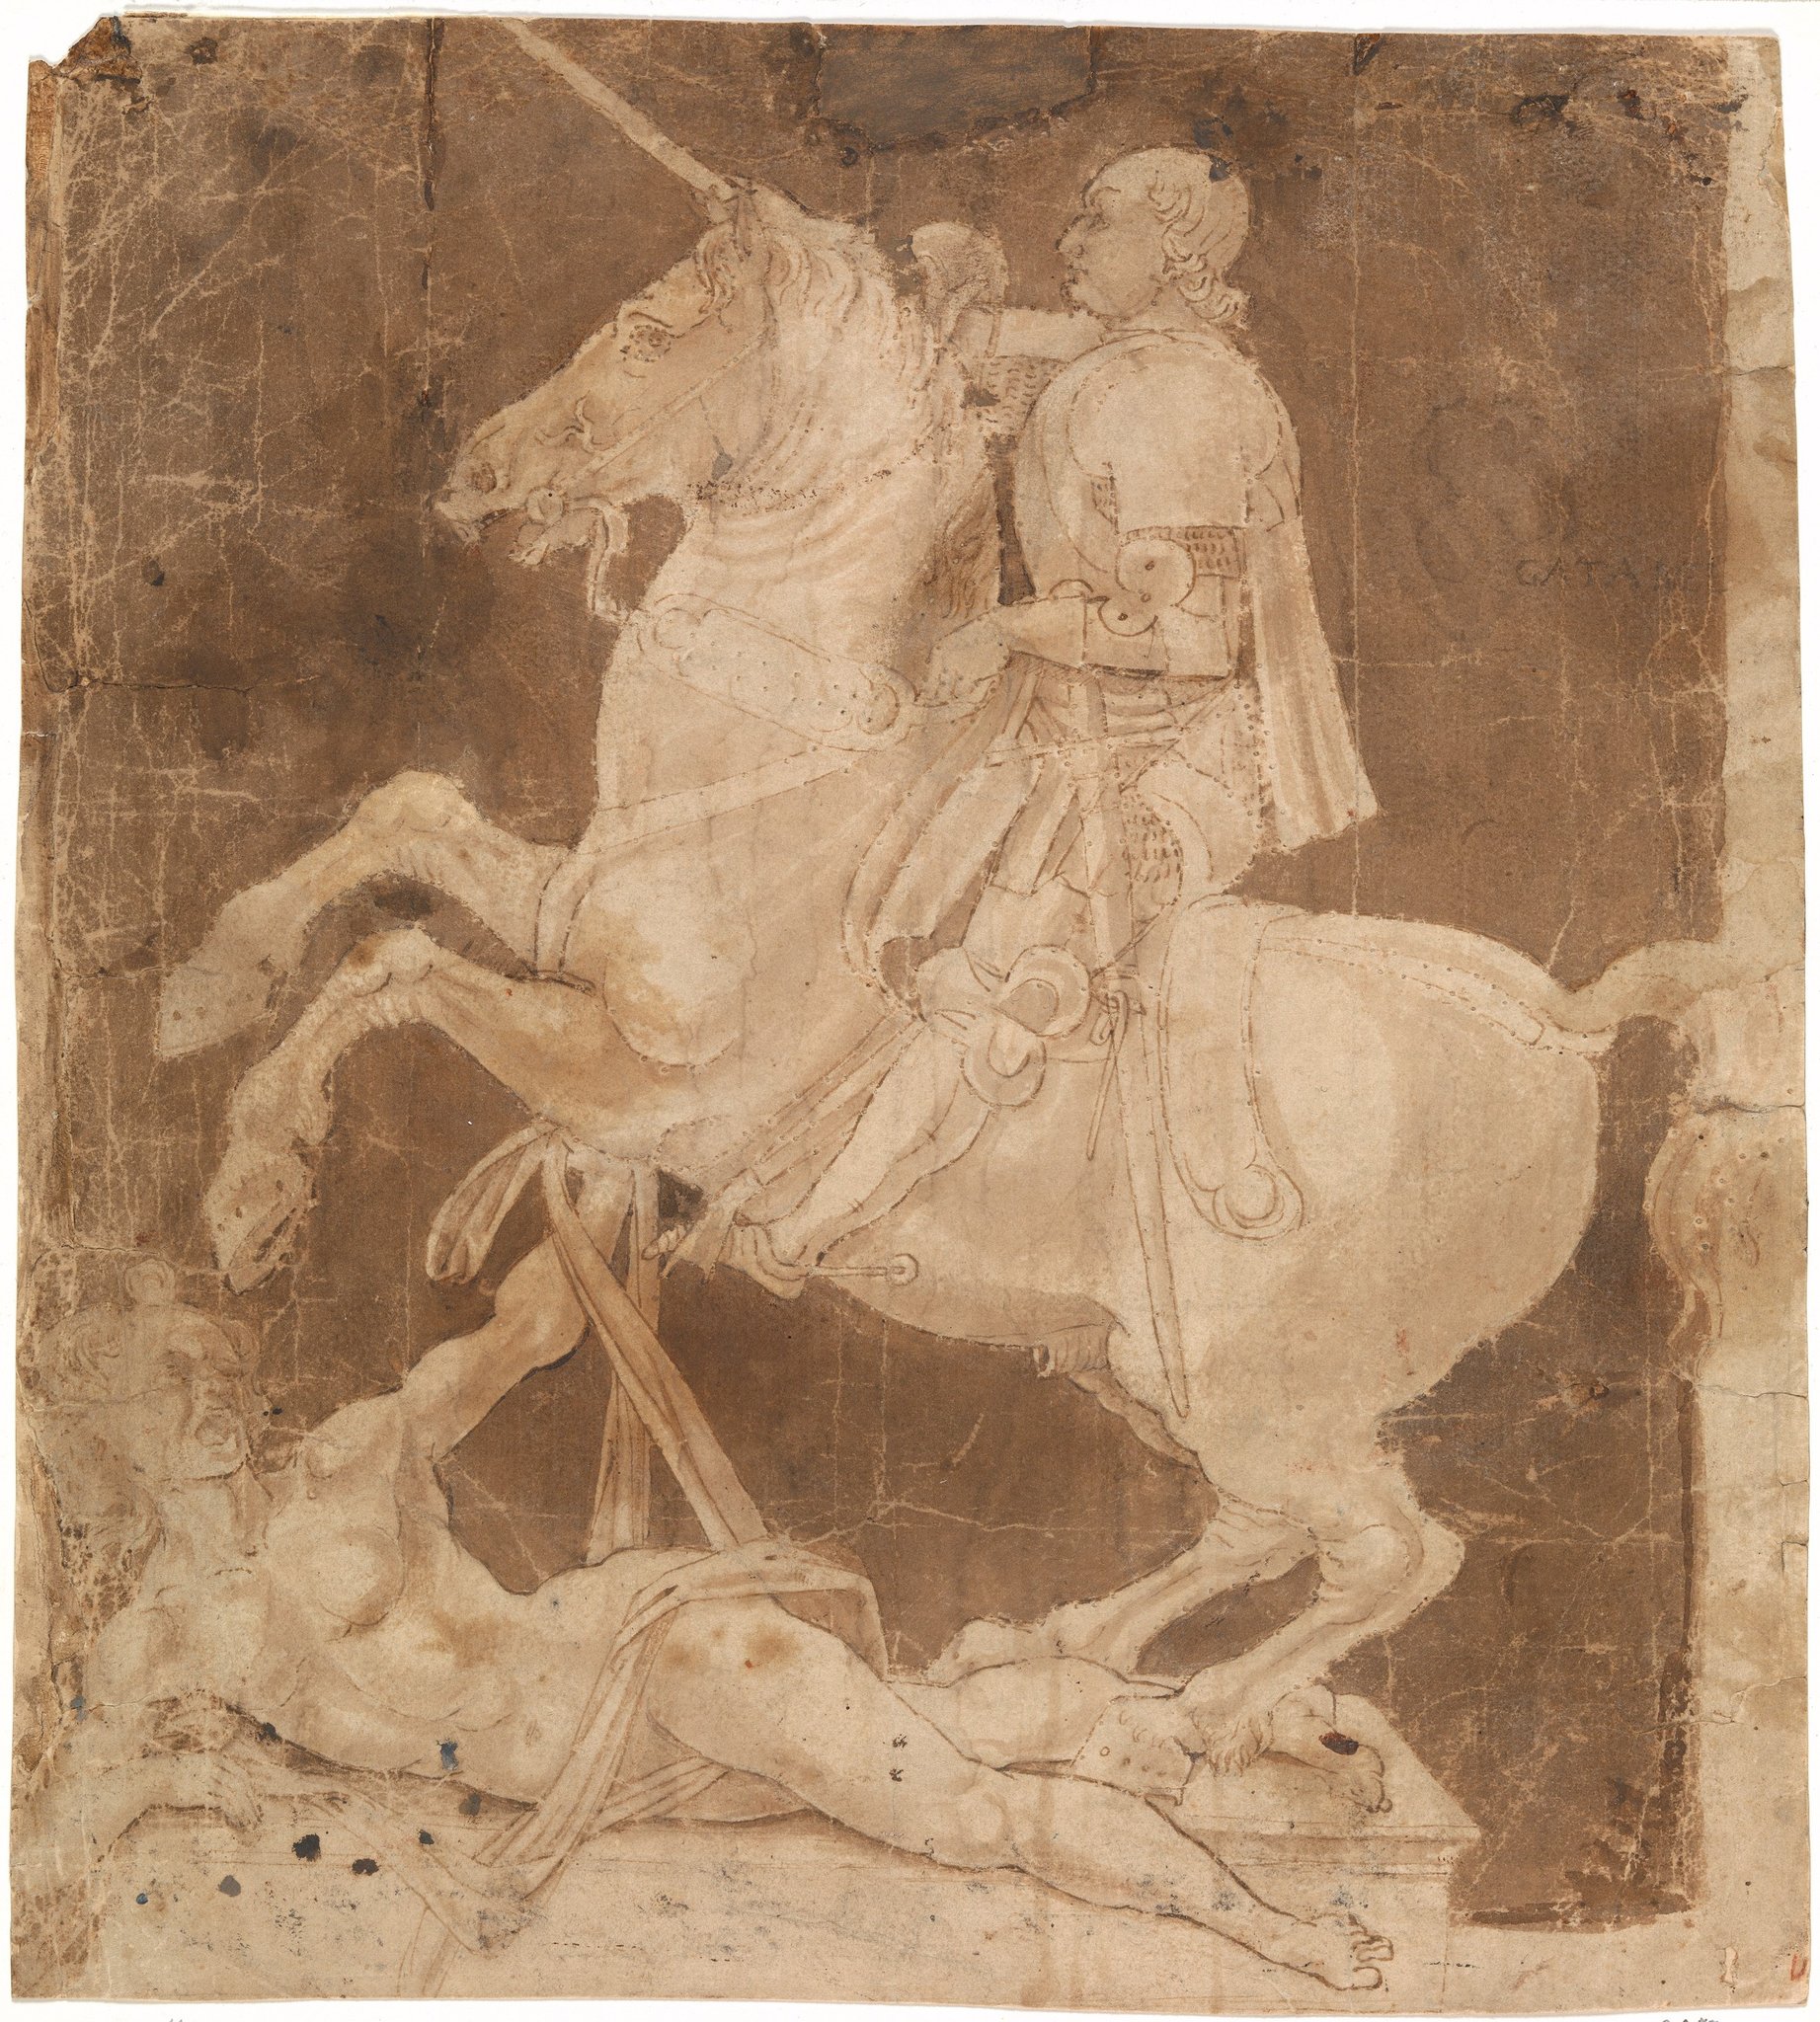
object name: drawing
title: Study for the Equestrian Monument to Francesco Sforza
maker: antonio pollaiuolo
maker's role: artist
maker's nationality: italian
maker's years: 1432-1498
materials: ink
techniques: pen, transfer, wash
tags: men,horses